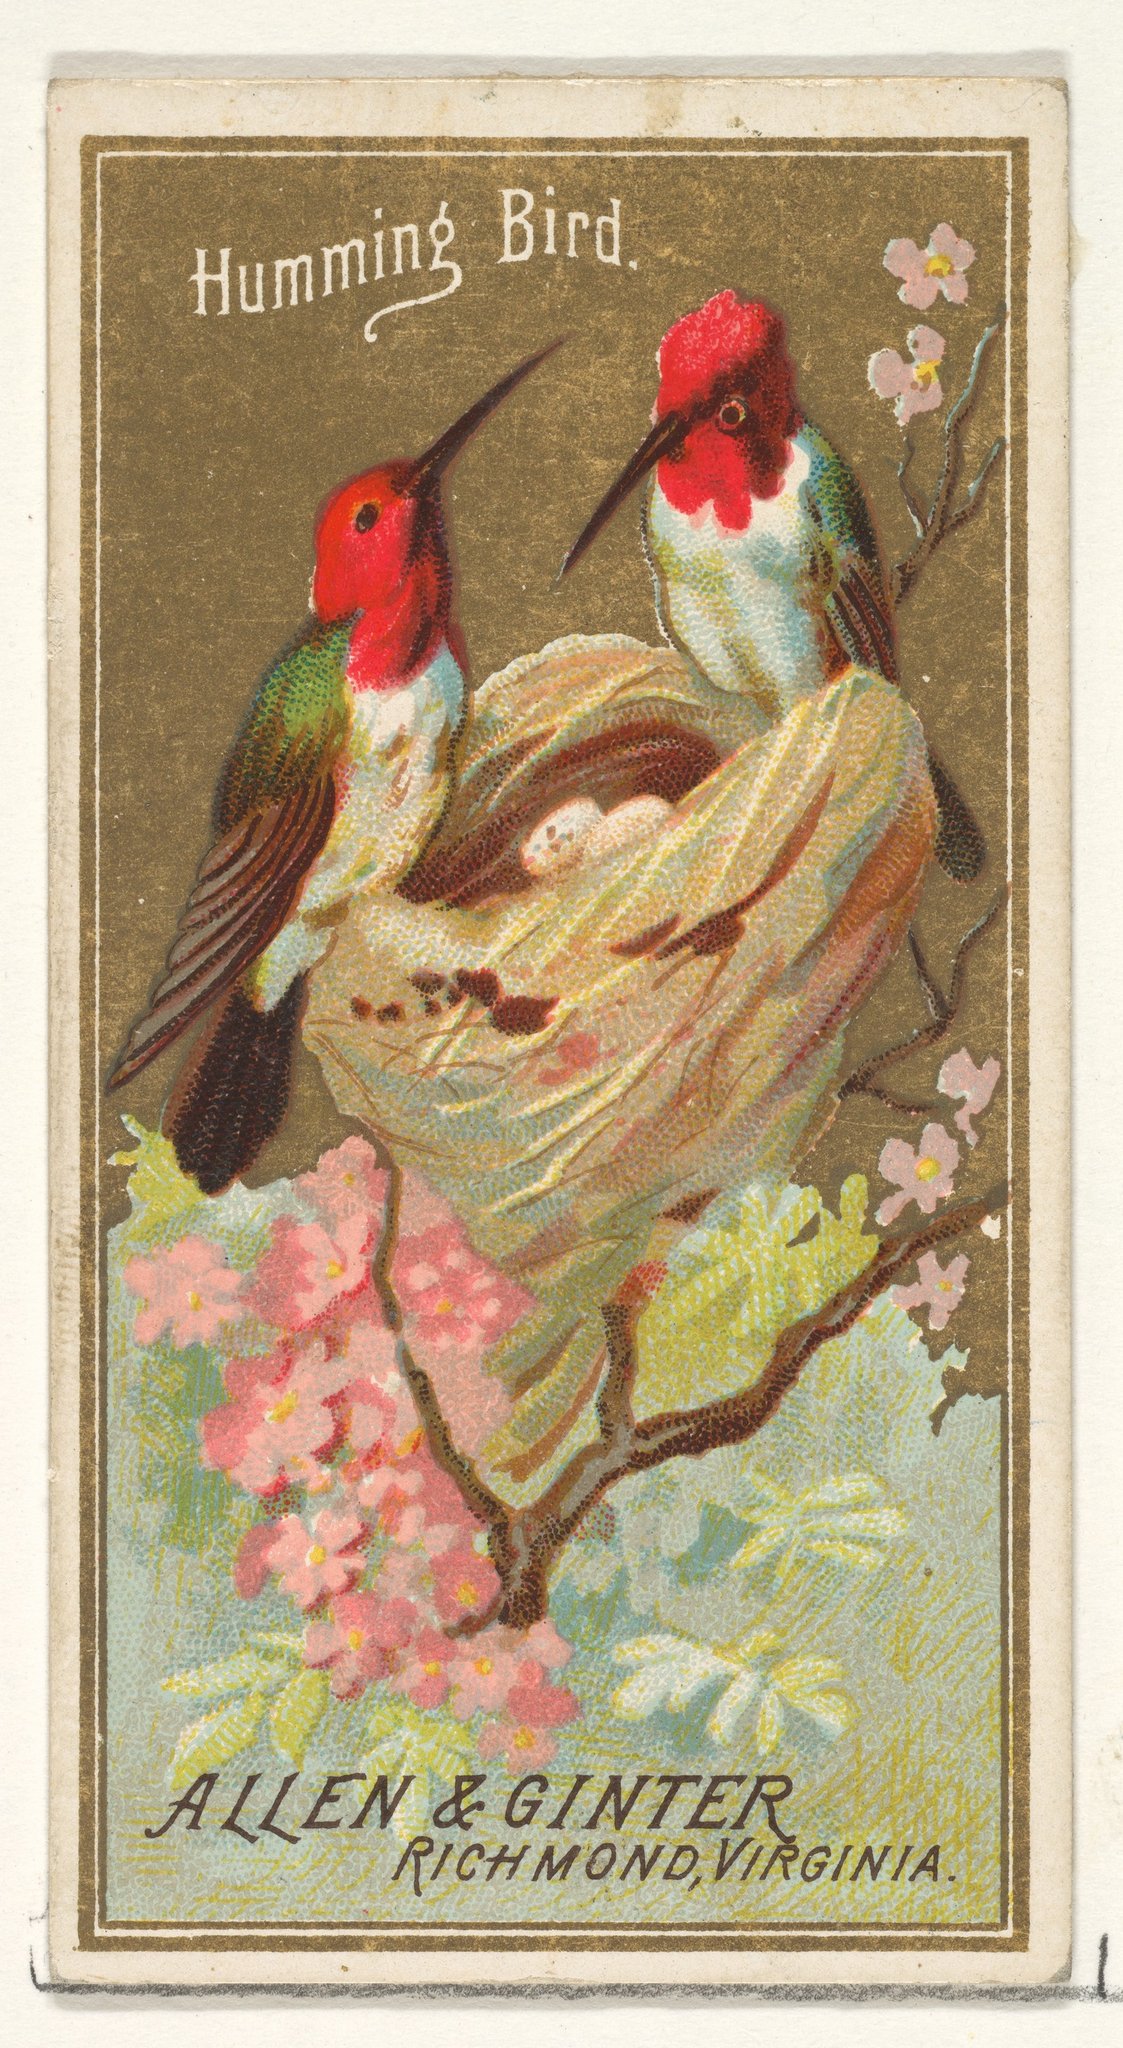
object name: print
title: Hummingbird, from the Birds of America series (N4) for Allen & Ginter Cigarettes Brands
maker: allen & ginter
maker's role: publisher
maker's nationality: american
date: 1888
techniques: color lithograph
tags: birds